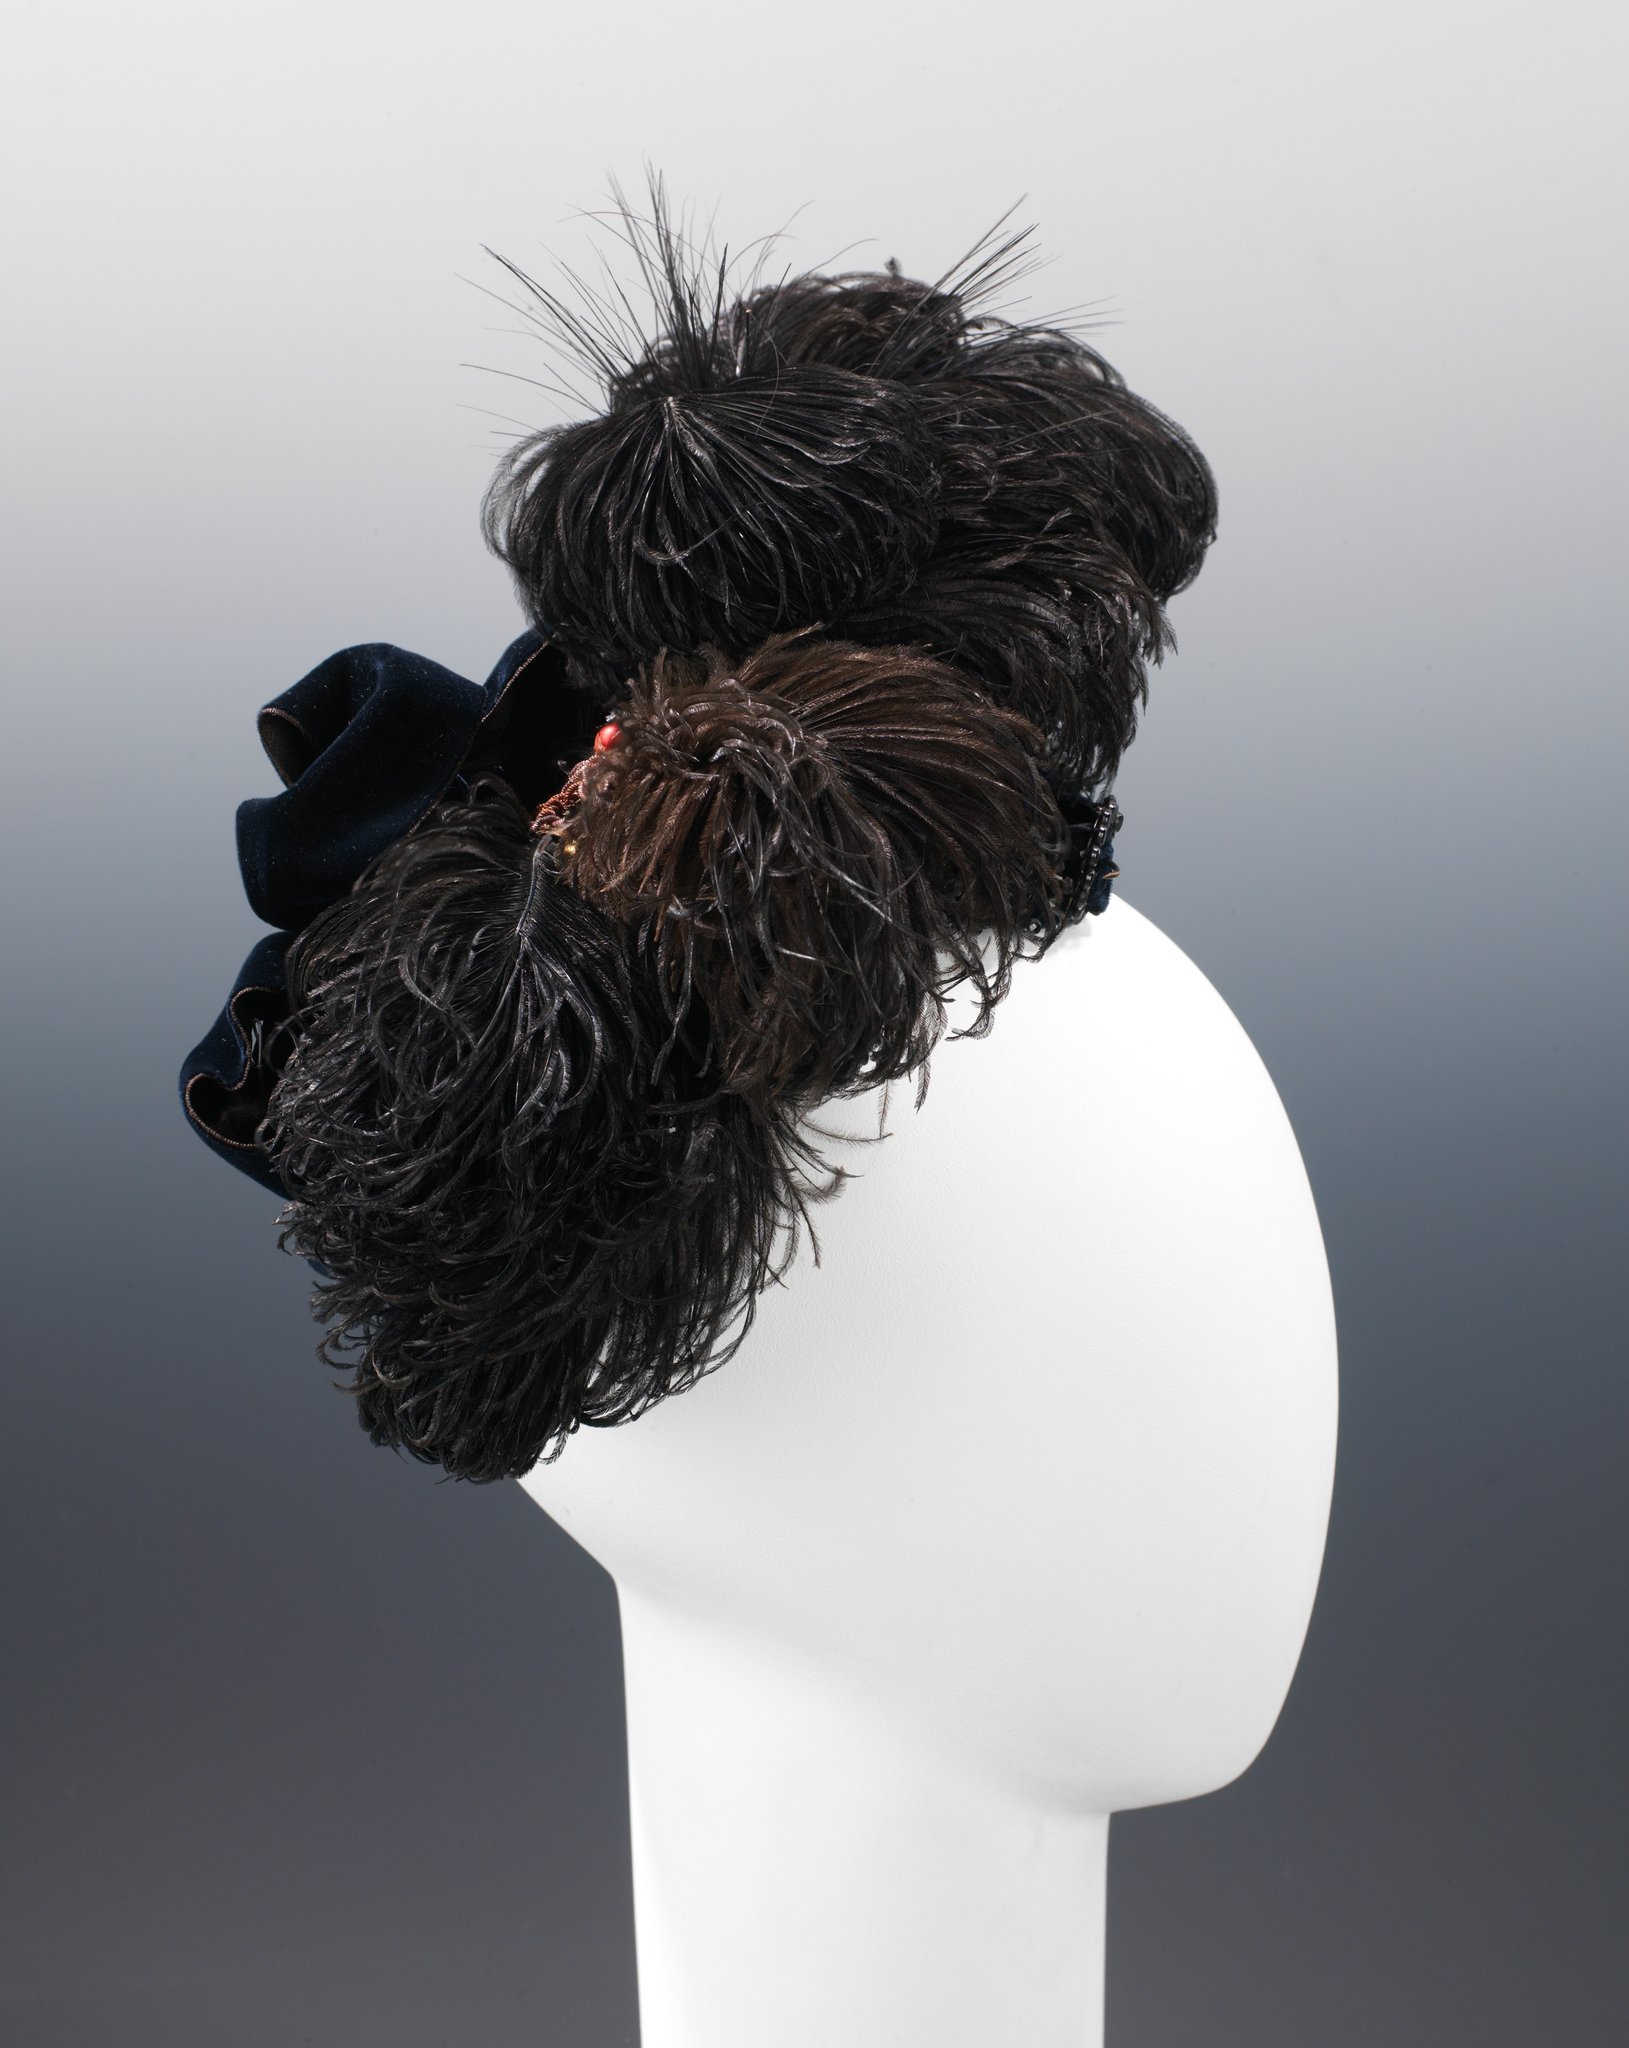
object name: evening hat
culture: american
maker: carpenter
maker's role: designer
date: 1888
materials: feather, metal, silk